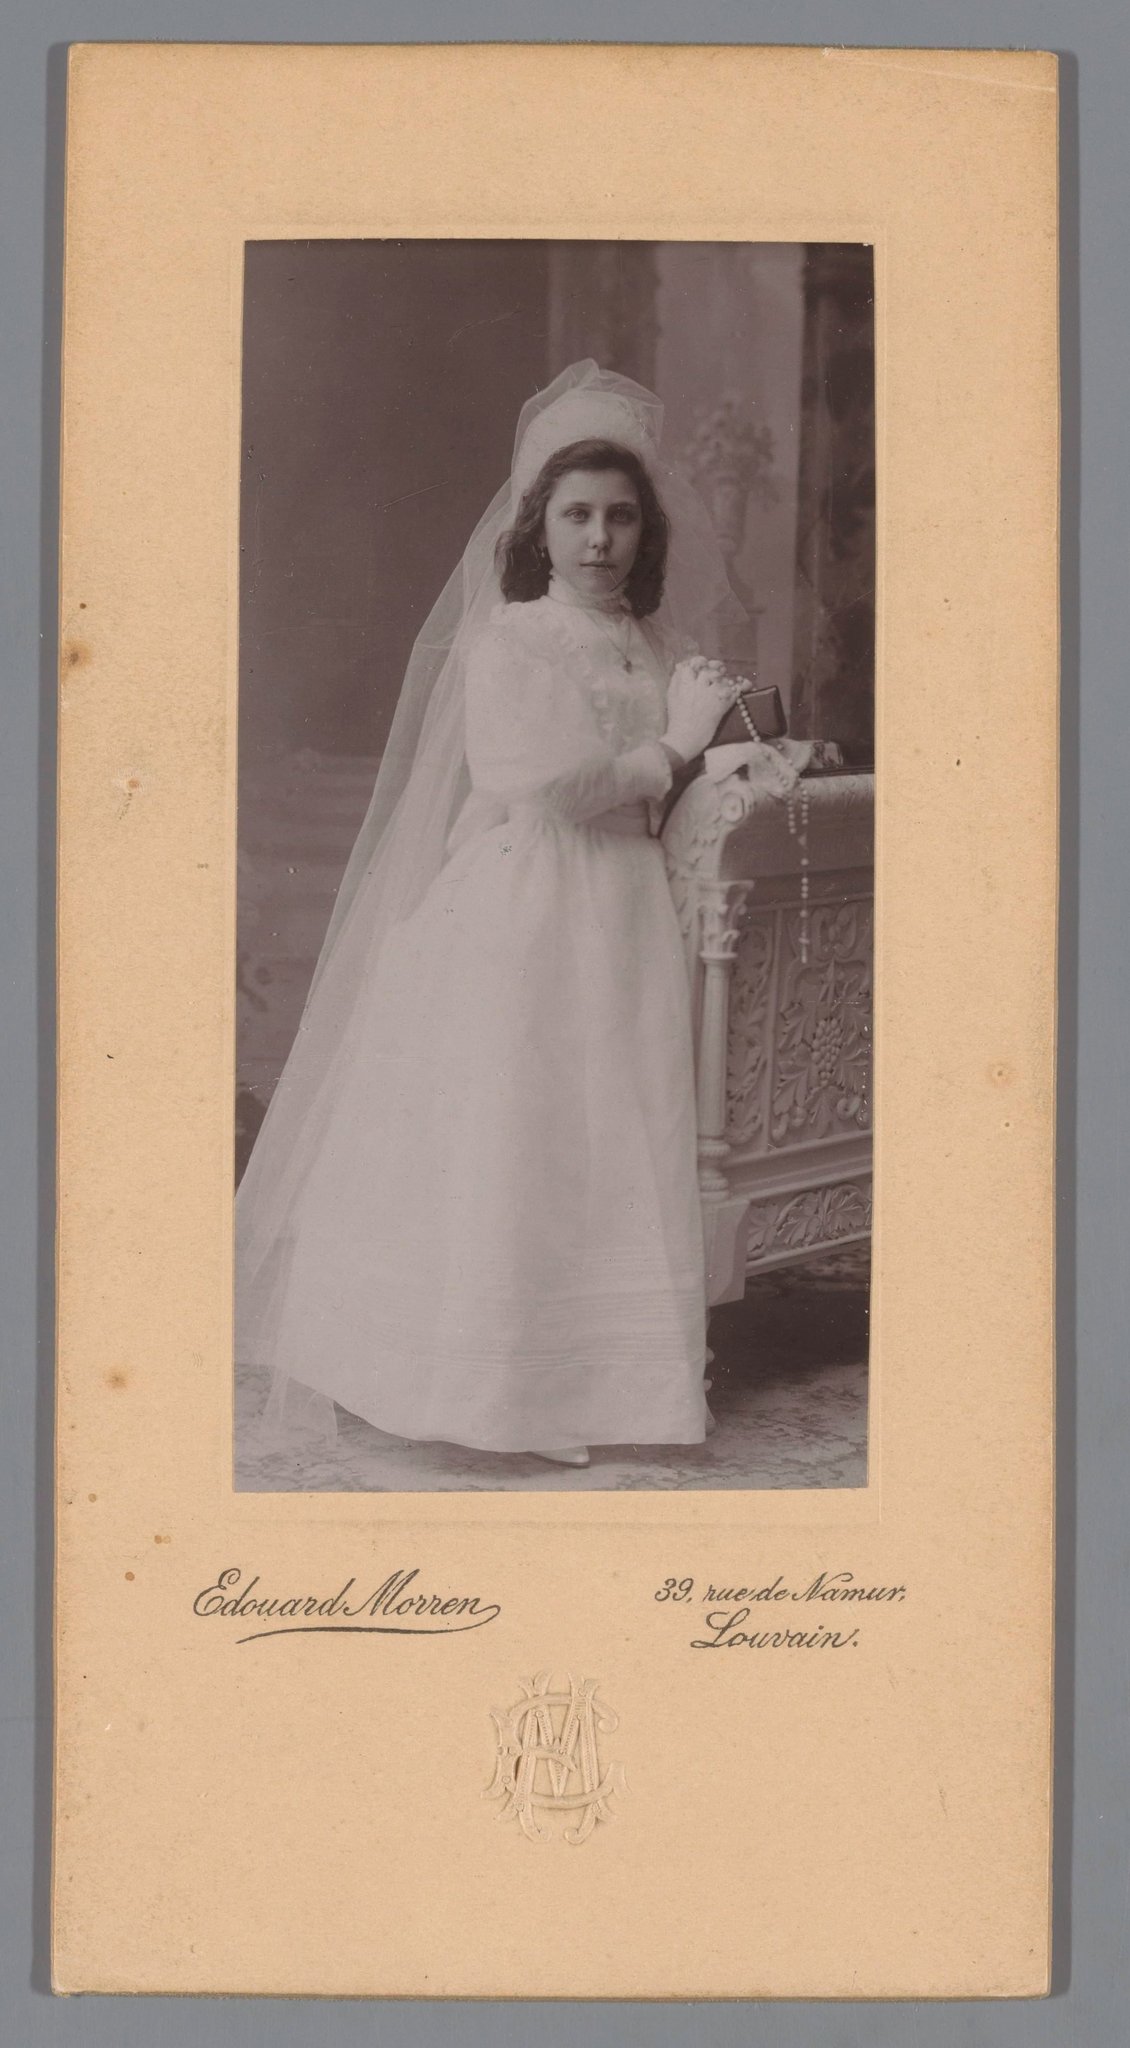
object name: photograph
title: Portret van een onbekende bruid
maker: edouard morren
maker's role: fotograaf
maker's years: 1867-1939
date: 1890-1908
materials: cardboard, photographic support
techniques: daylight paper print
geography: leuven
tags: bride (in wedding-dress)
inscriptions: name: ‘EM’, annotation: ‘Kleine gedenknis van mijn kleinste zusje, aan mijne lieve Maria, ter herinnering aan de gelegenheid, die me eens liet uitvliegen van uwe Joséphine Brugge, den 24 juni 1908.’